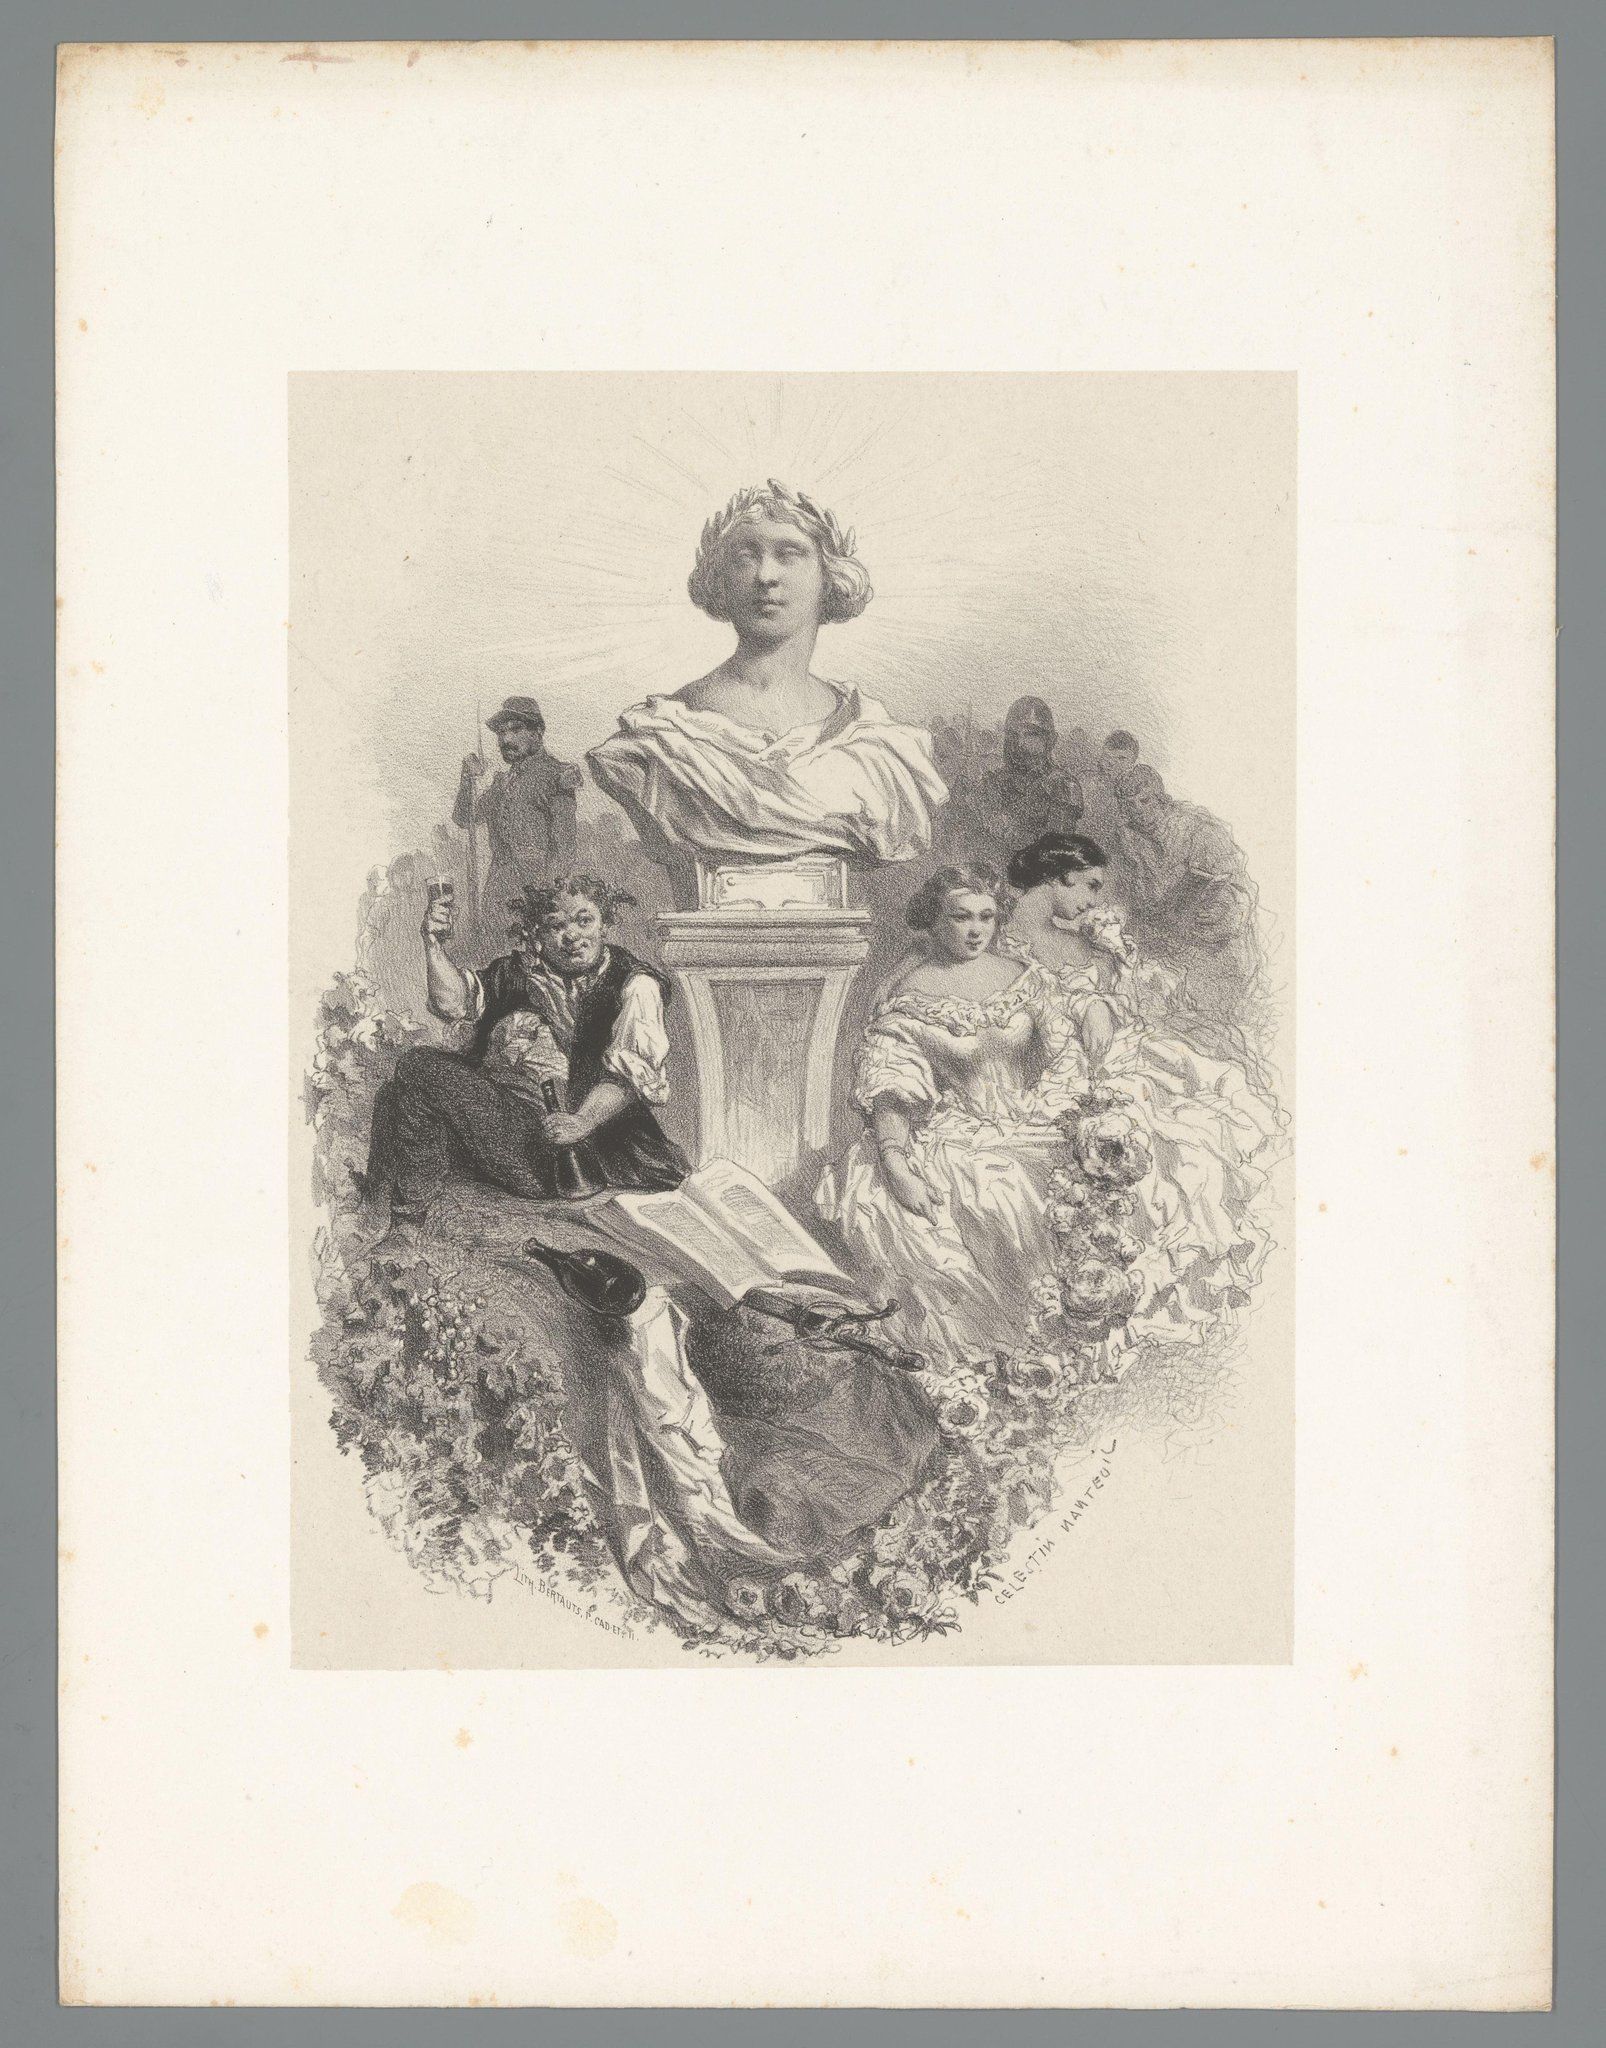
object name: print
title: Borstbeeld omringd door Bacchus, twee vrouwen en andere figuren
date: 1851-1865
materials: paper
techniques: lithograph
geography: paris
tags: fashion, clothing, (story of) bacchus (dionysus), liber, monument, statue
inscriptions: collector's mark: Lugt 964